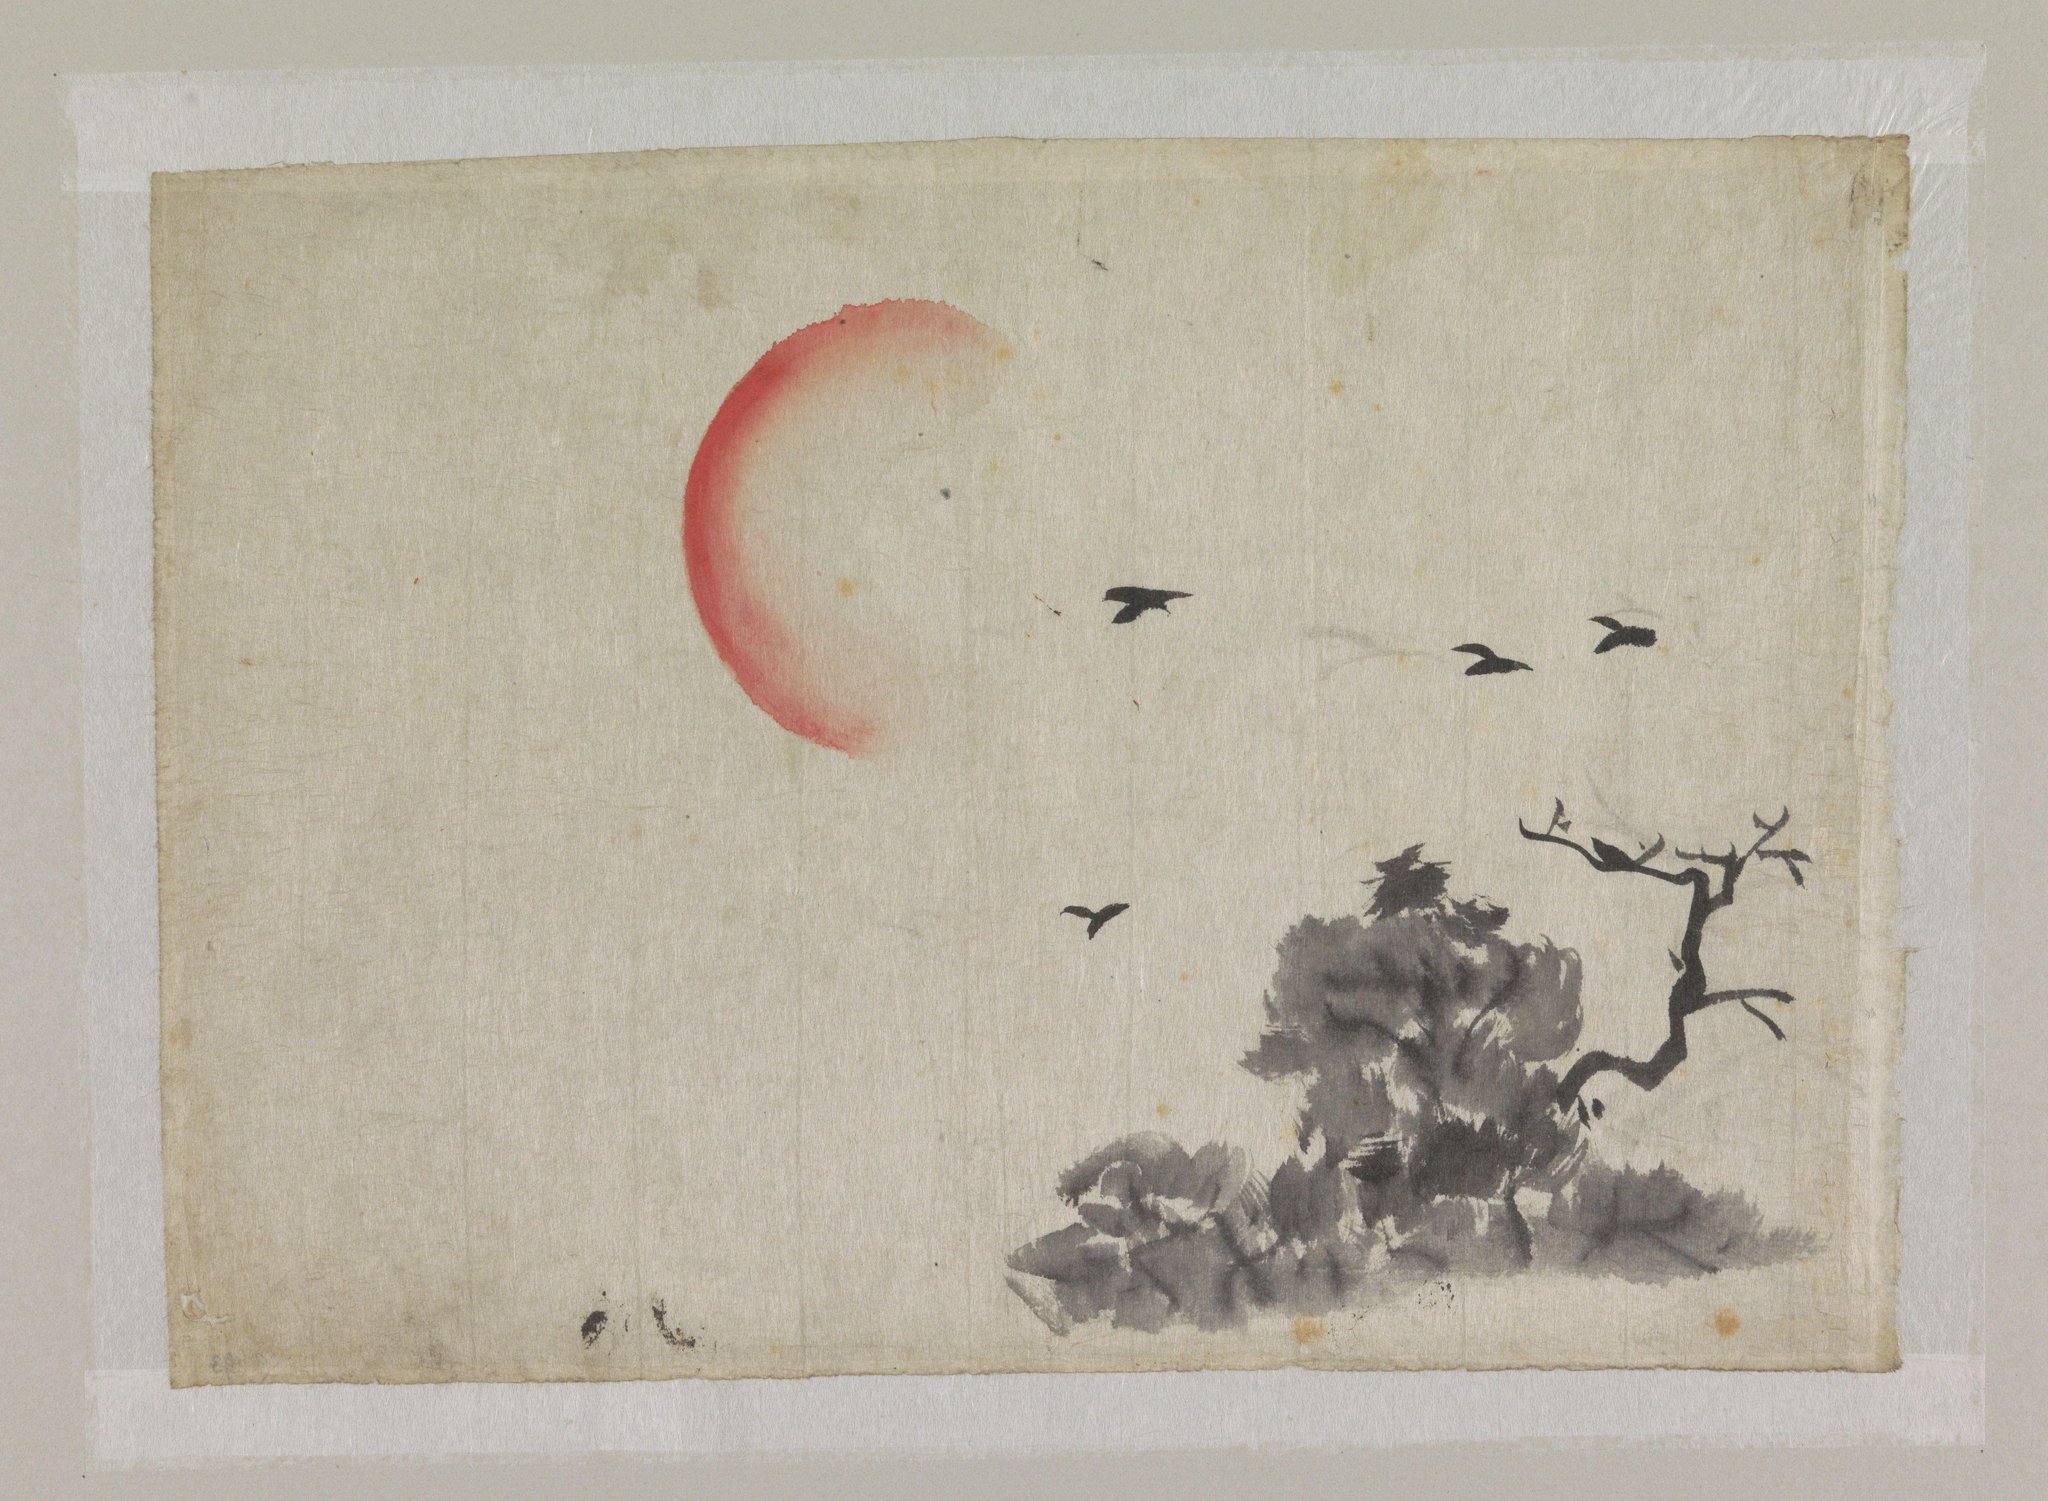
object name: drawing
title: Landschap met ondergaande zon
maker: ichirakasai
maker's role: draughtsman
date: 1700-1900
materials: paper, watercolor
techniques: brush